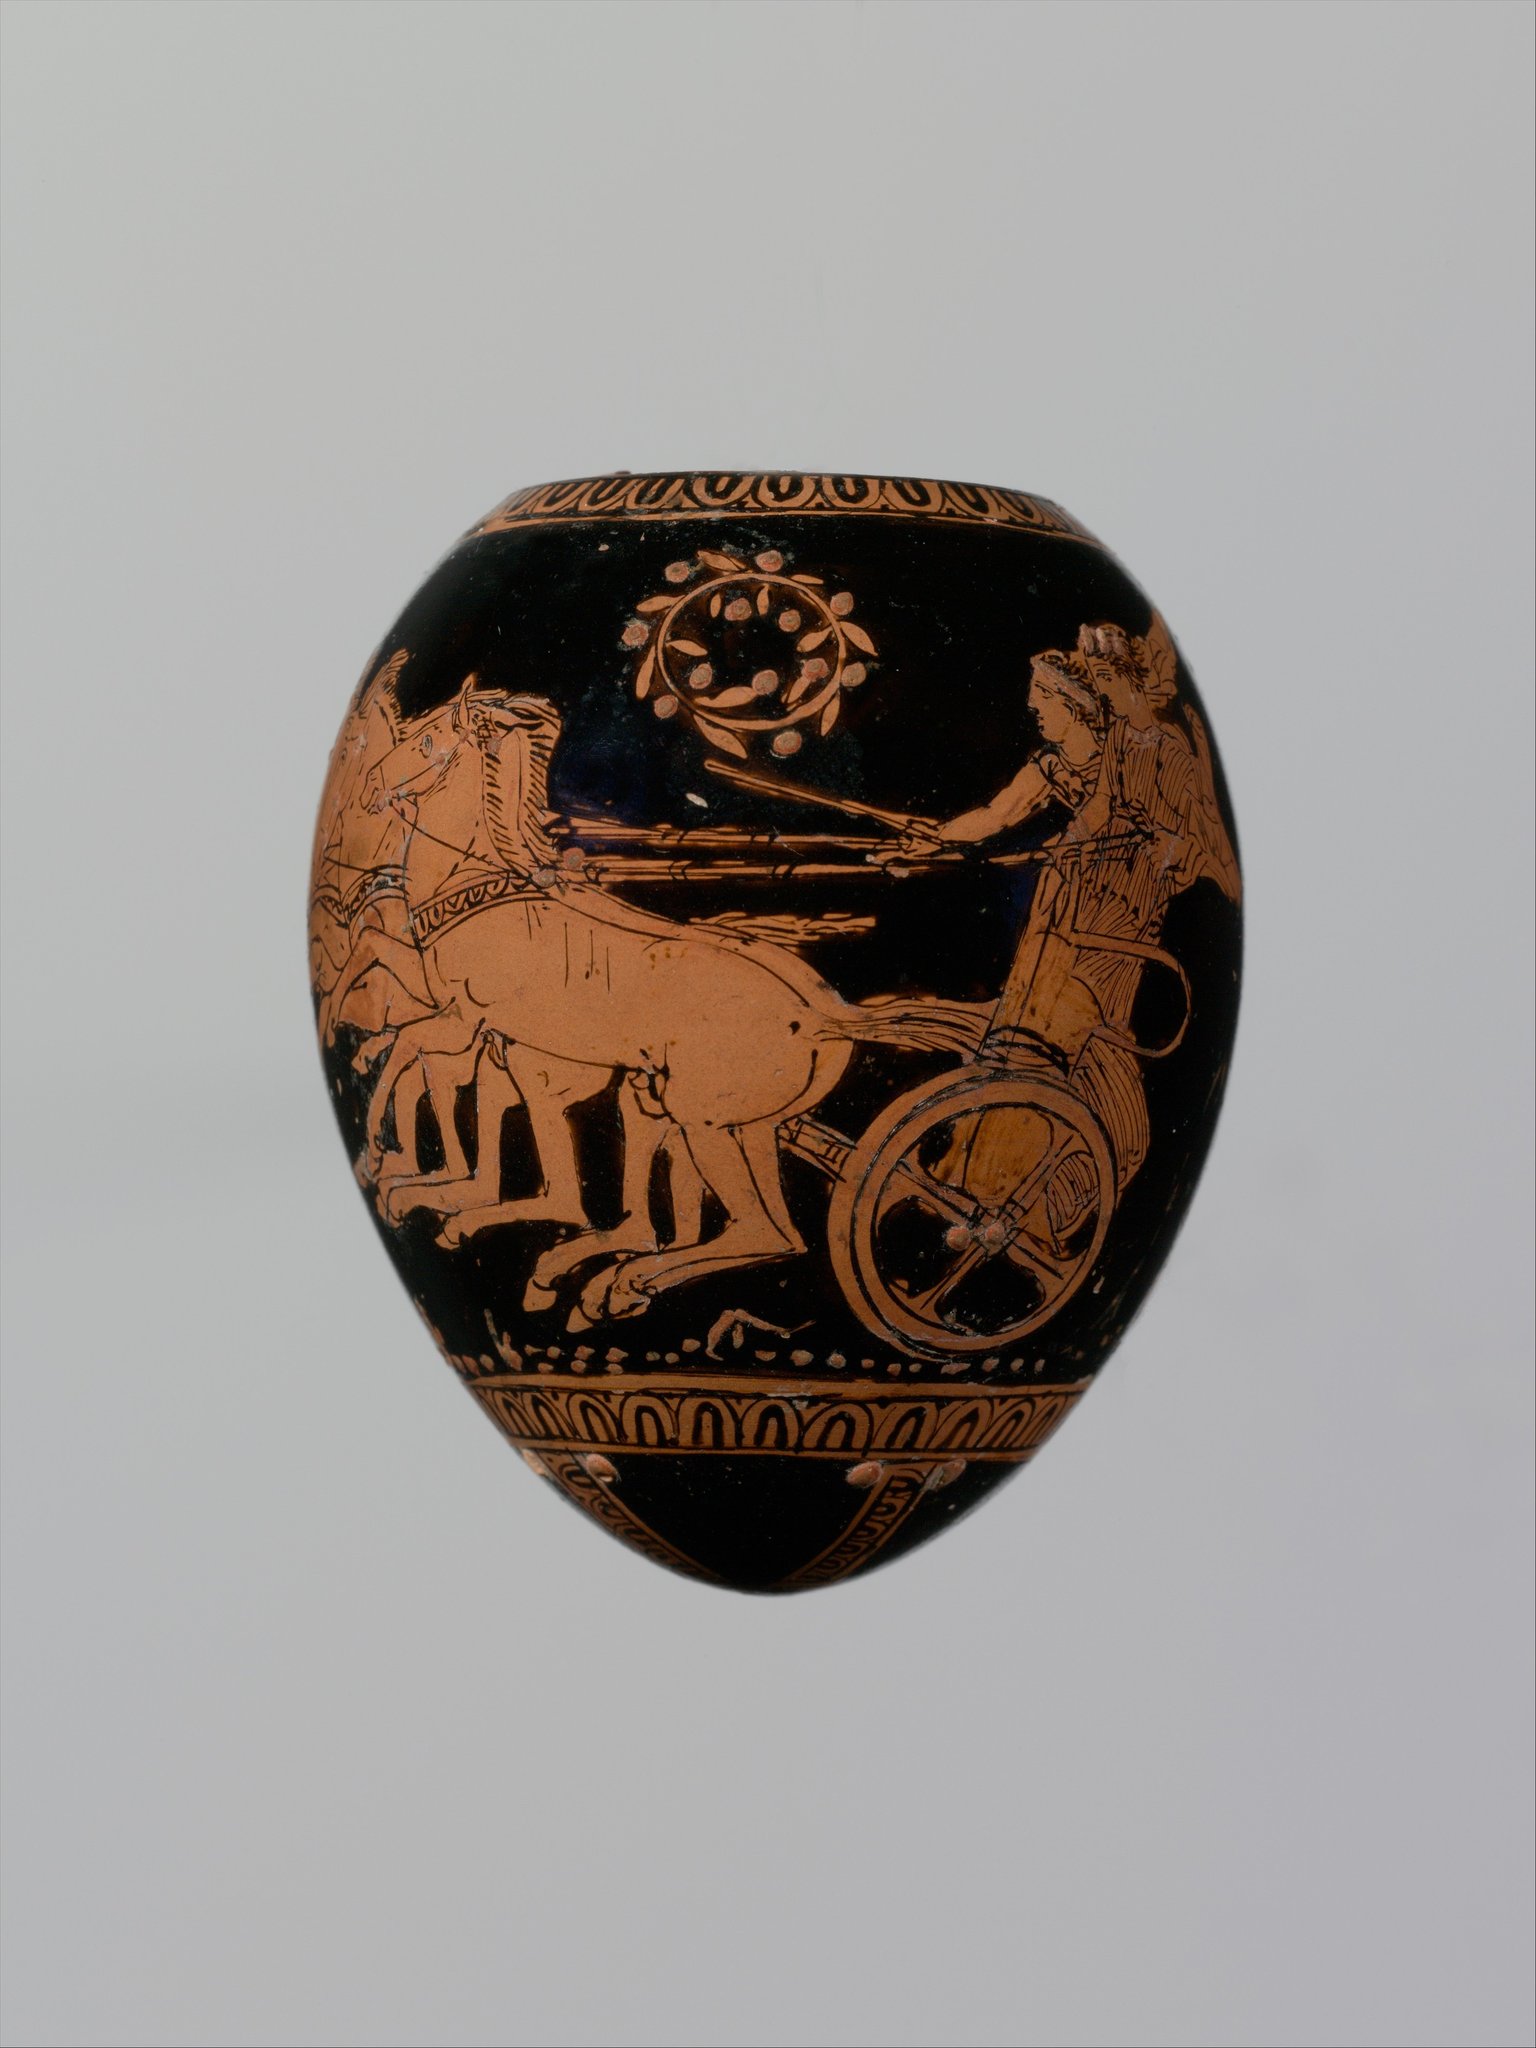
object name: oon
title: Terracotta oon (egg)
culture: greek, attic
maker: washing painter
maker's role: artist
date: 420-410 BCE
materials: terracotta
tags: women,horses,chariots